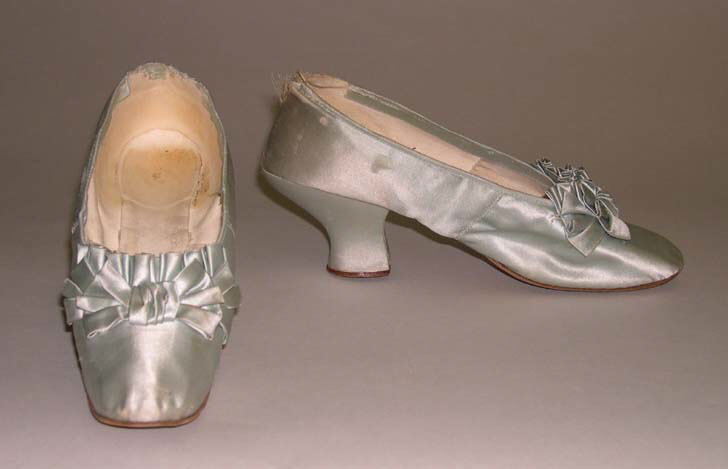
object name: shoe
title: Shoes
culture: american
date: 1870-1879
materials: leather, silk